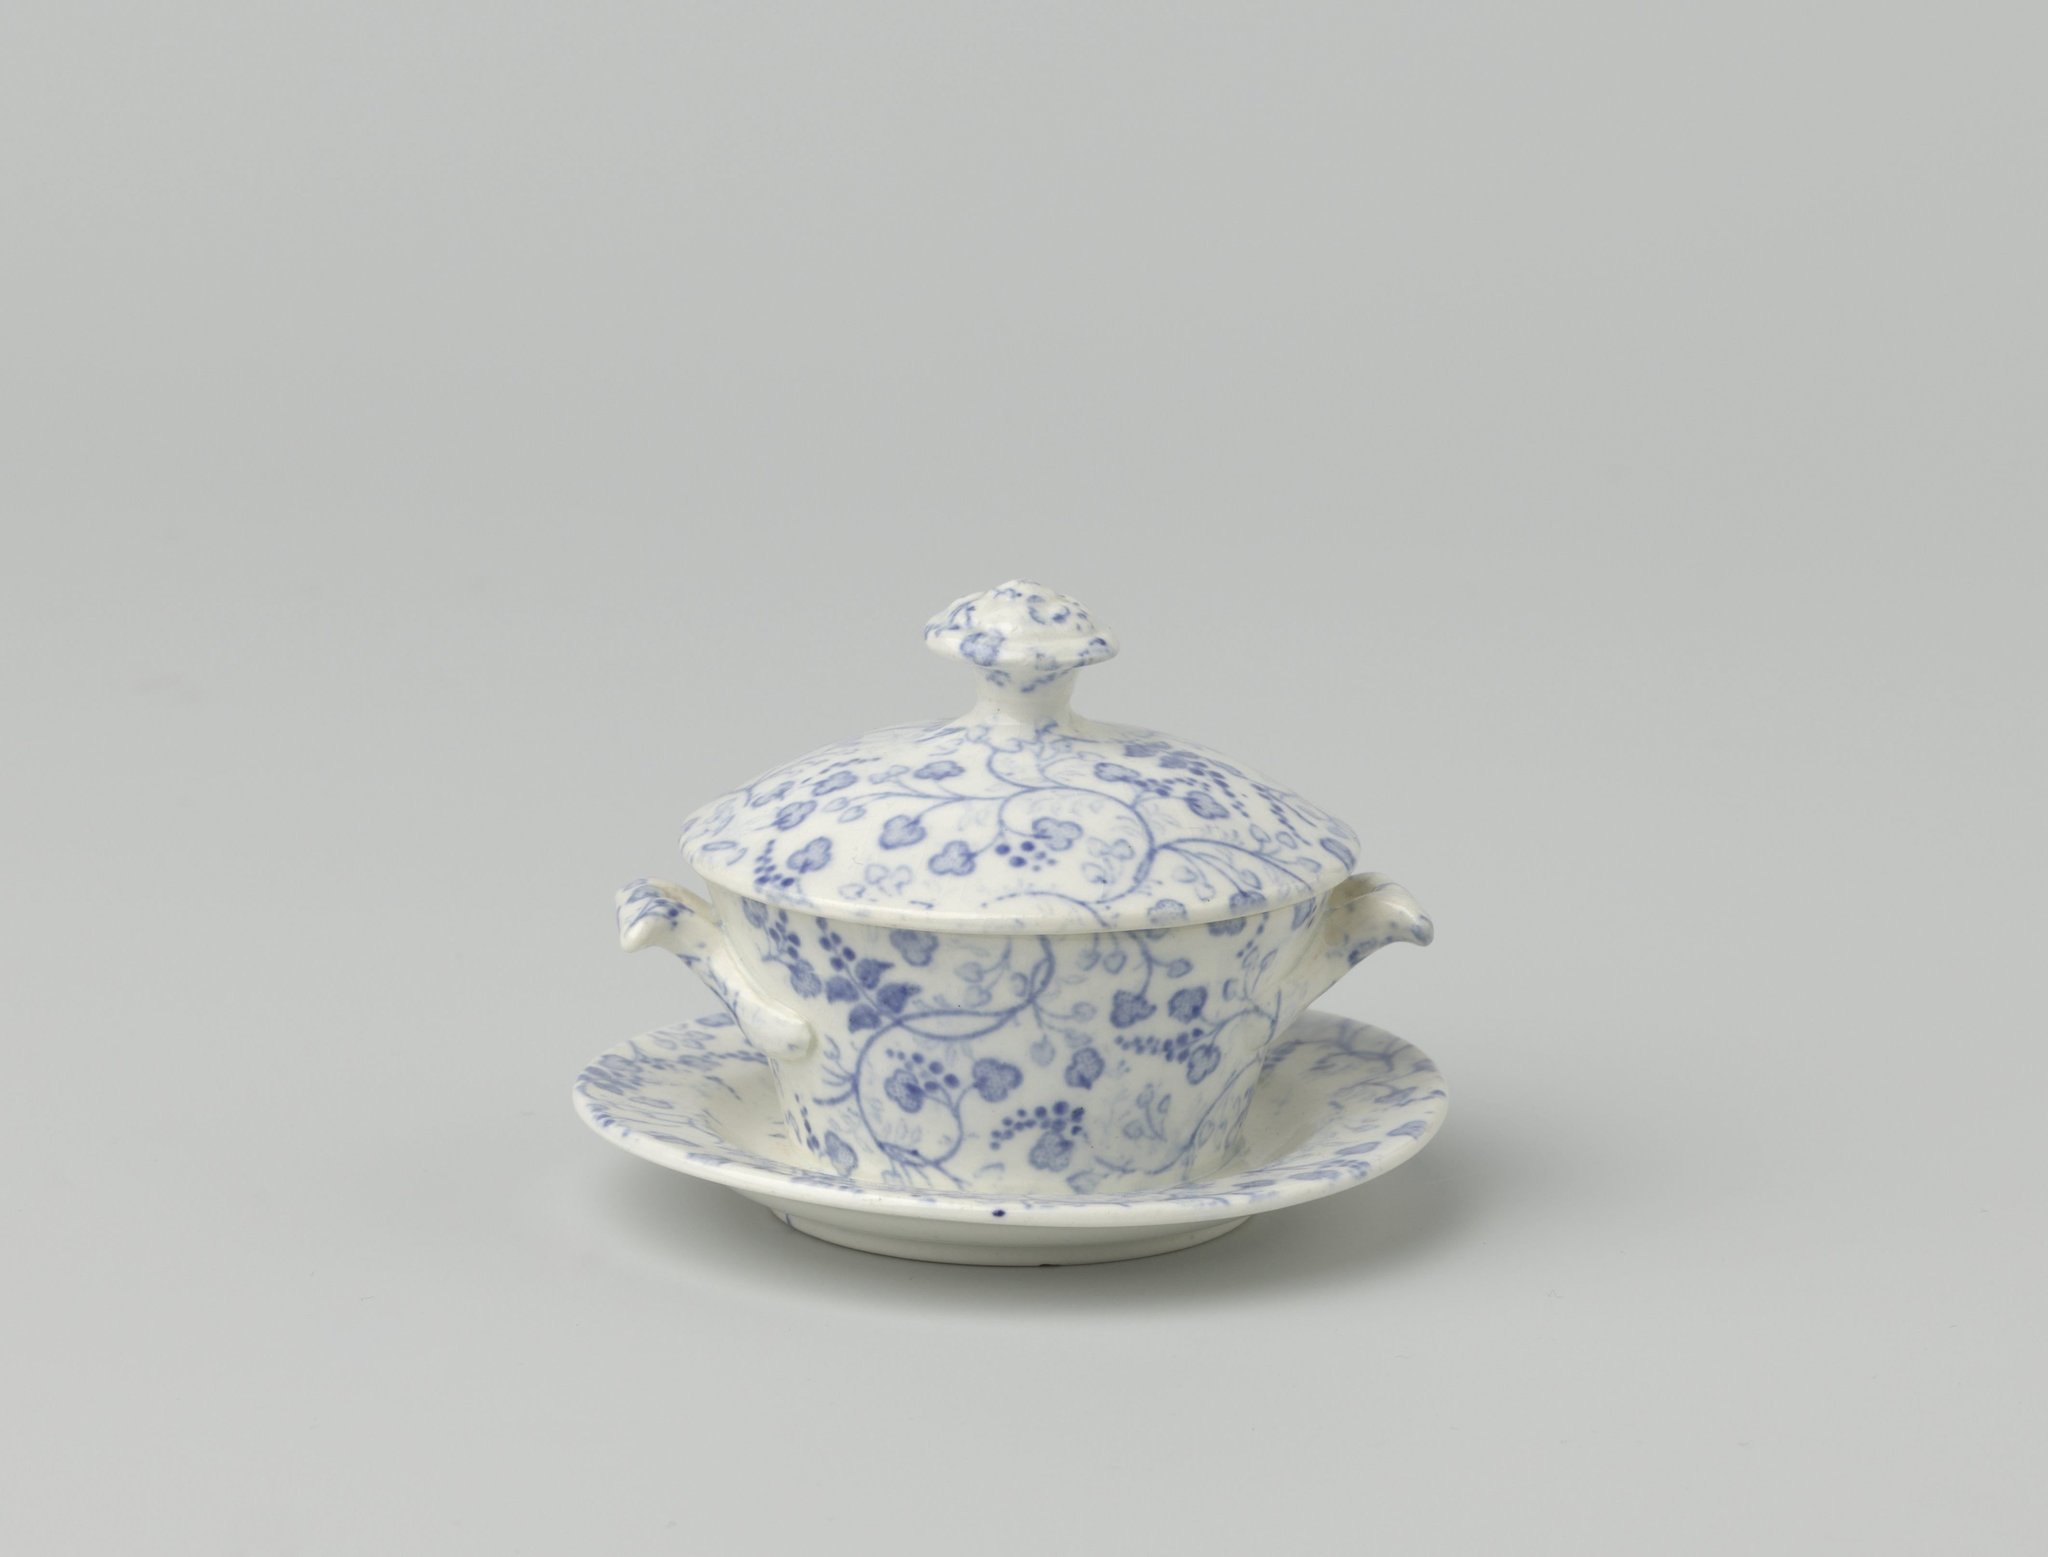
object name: butter dish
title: Botervloot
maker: petrus regout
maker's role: plateelbakker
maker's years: 1801-1879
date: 1867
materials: creamware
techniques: transfer decoration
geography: maastricht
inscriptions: check stamp: ‘33’, mark: ‘PARSEME No 3’, check stamp: ‘PR // 33’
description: Botervloot op vaste onderschotel van aardewerk met blauw doorlopend bloemendecor, behorend tot een kinderservies. De ronde vloot heeft twee oren. Het ronde, gewelfde deksel wordt bekroond door een bloemvormige knop.